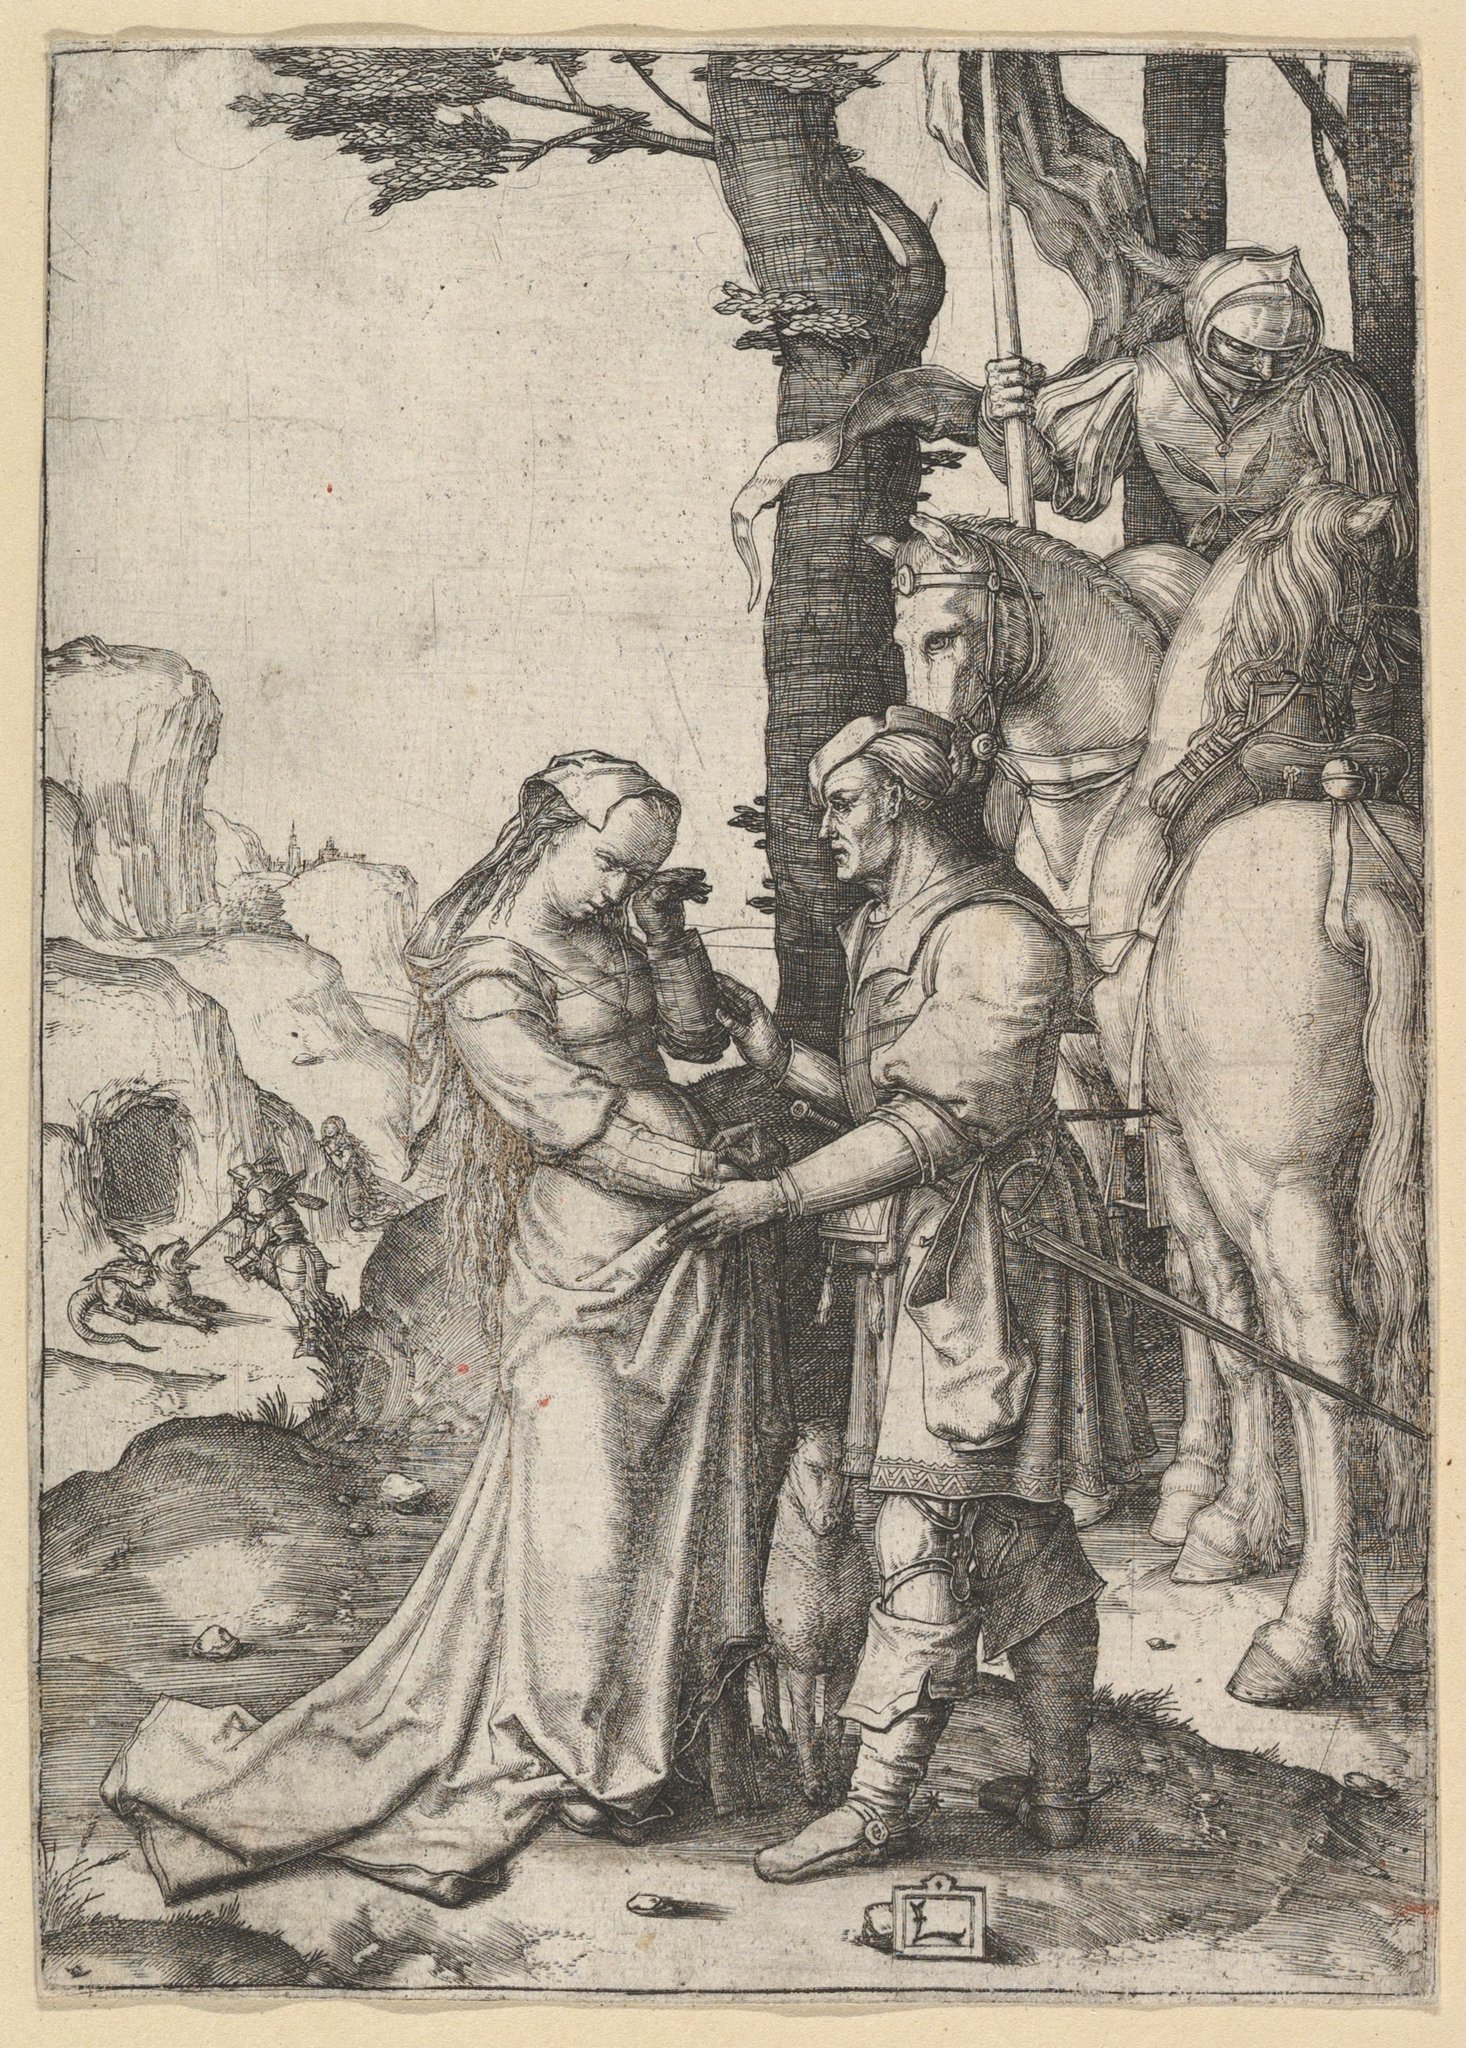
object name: print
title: St. George Liberating the Princess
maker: lucas van leyden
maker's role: artist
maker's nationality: netherlandish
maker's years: 1494-1533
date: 1508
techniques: engraving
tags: swords,princesses,horses,trees,saint george